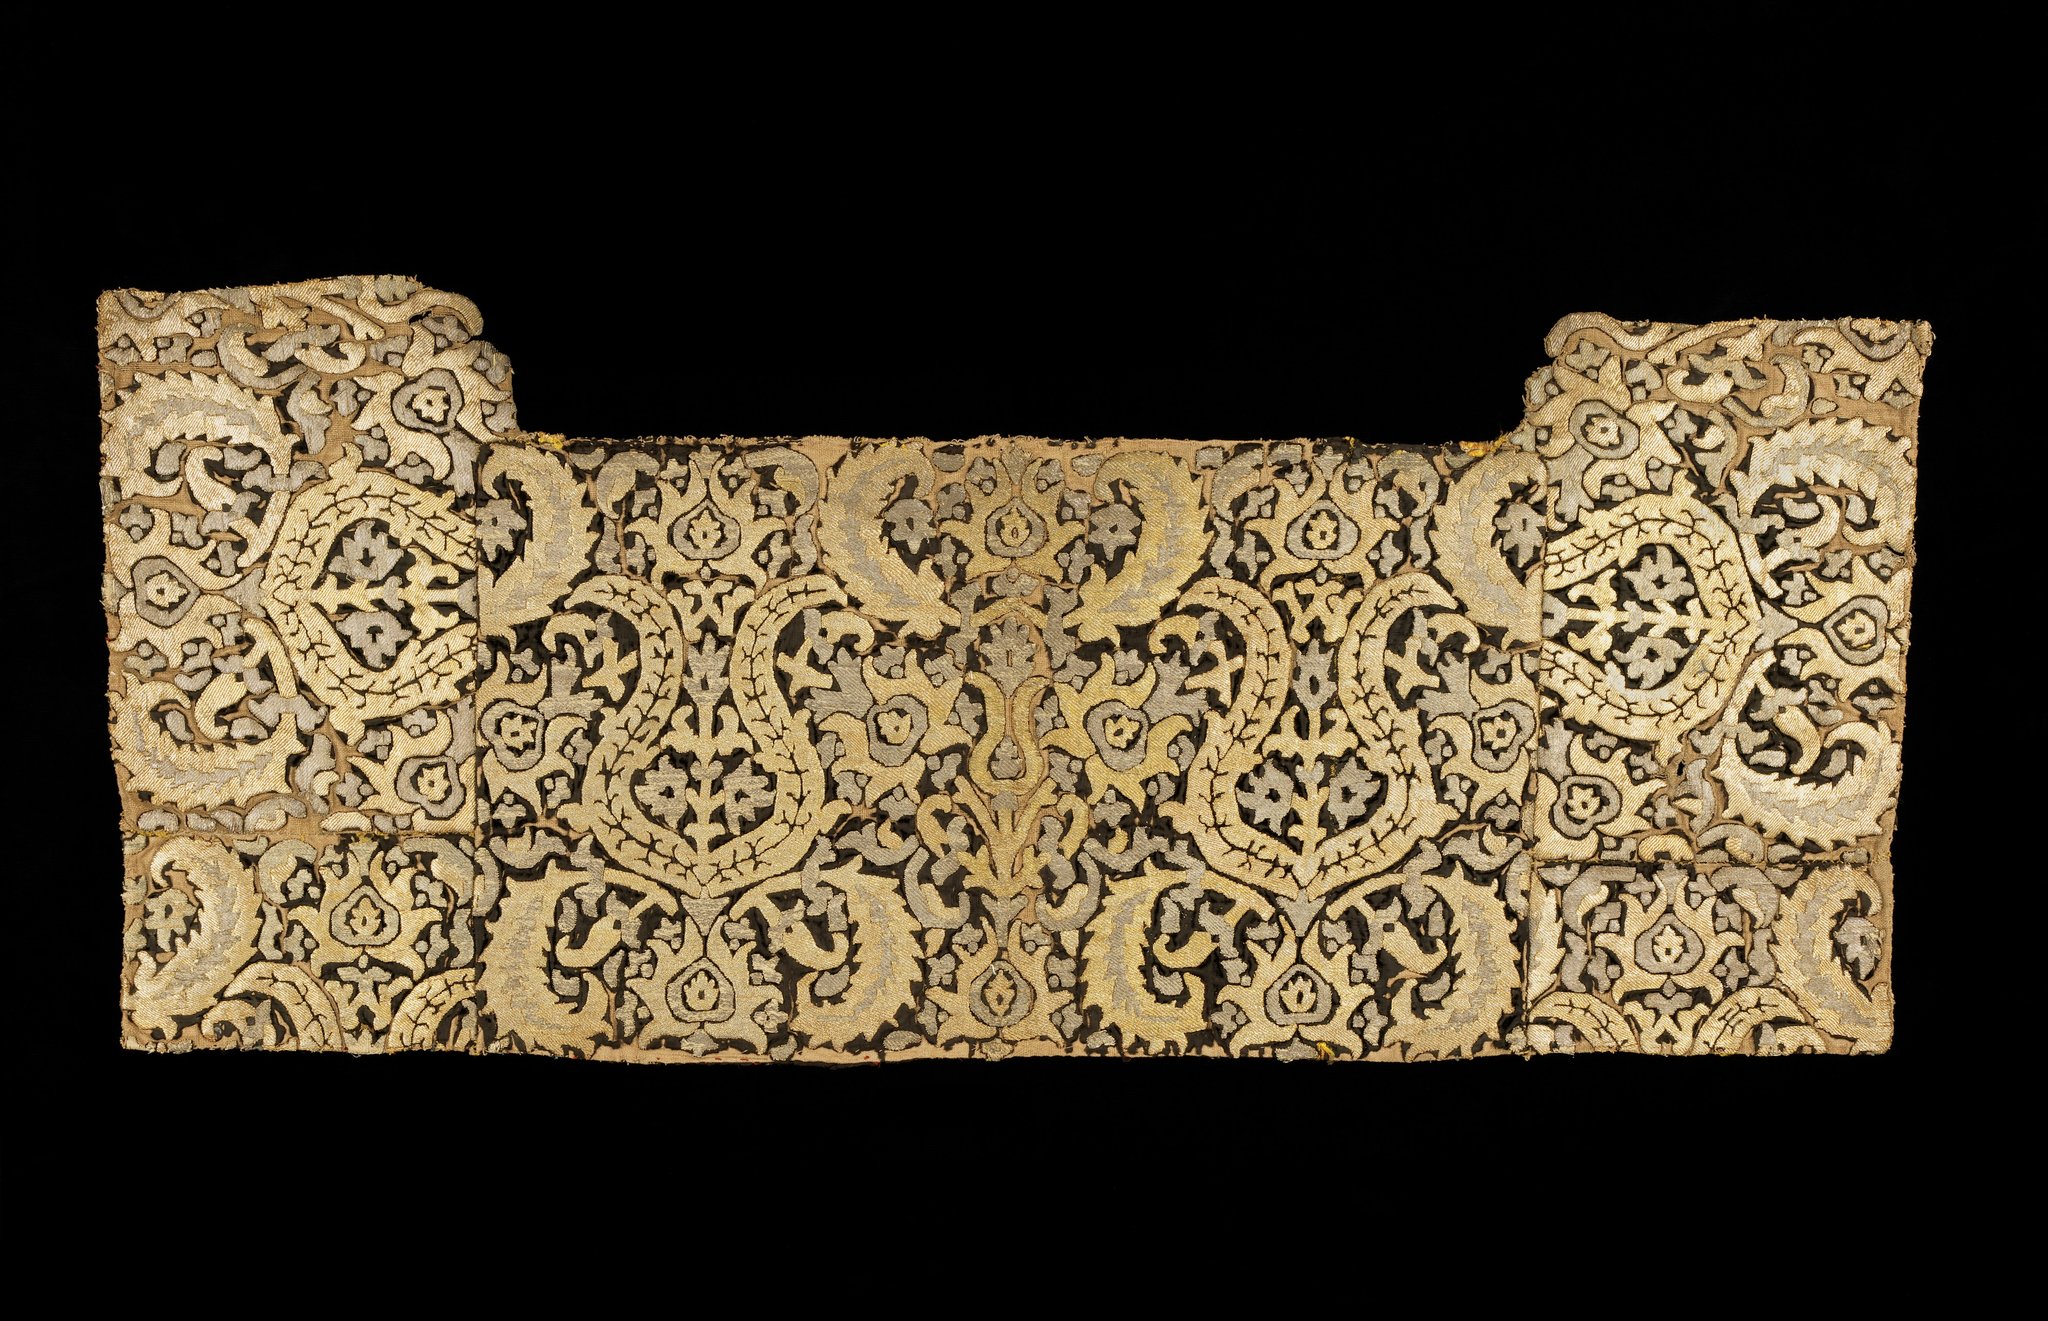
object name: vestment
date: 1667-1700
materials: linen, metal, silk